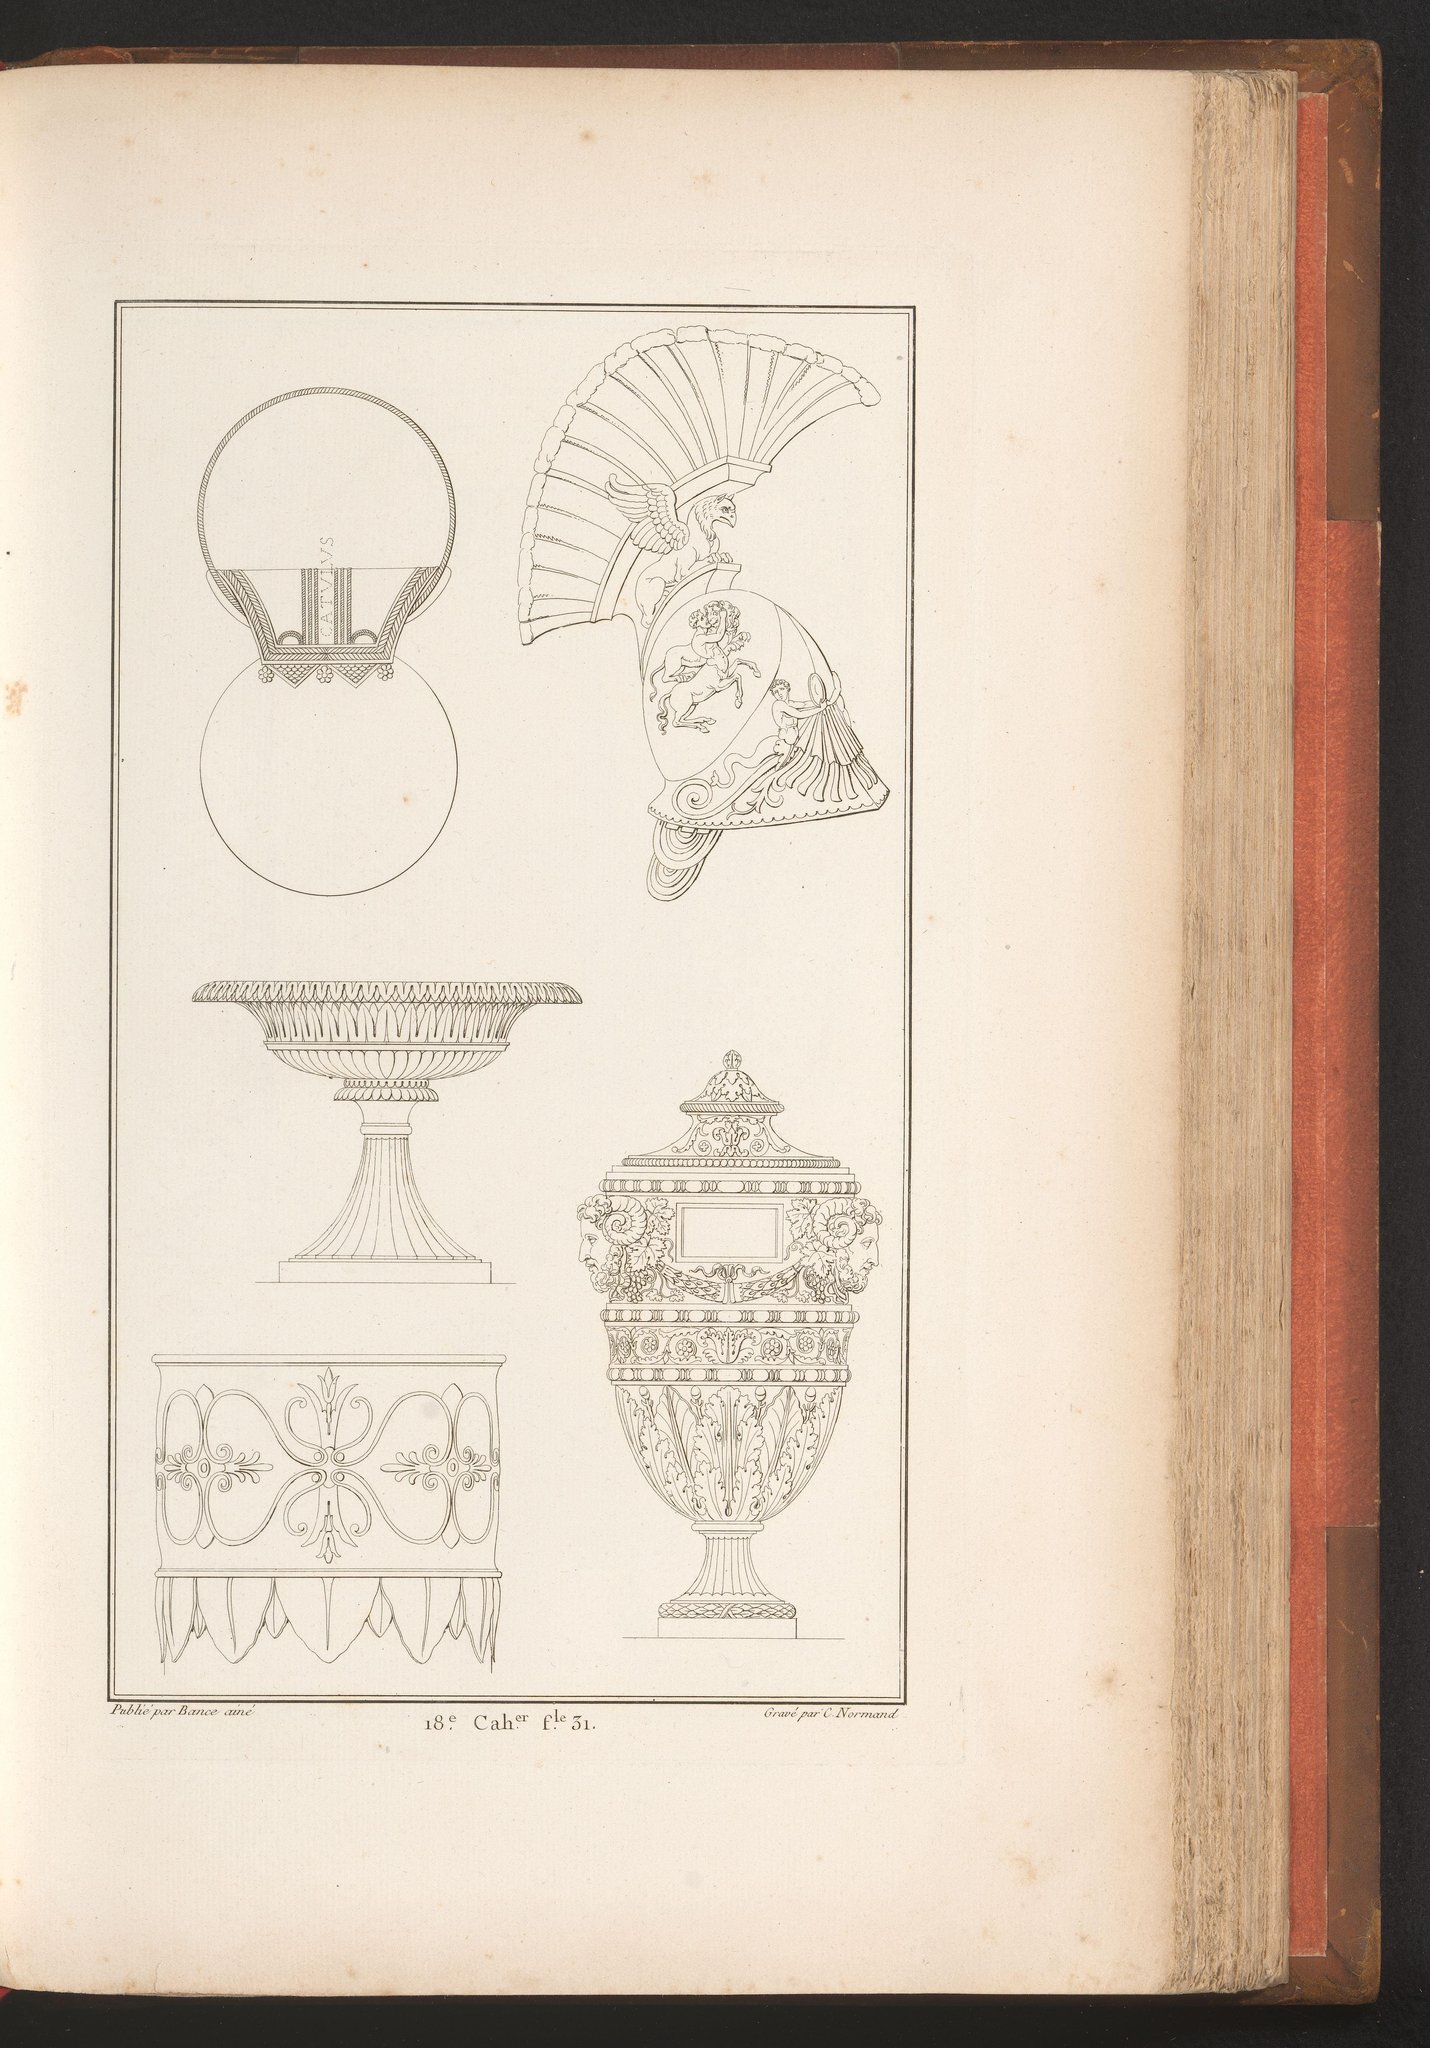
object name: ornament print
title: Diverse ornamenten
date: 1820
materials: paper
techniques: etching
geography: paris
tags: ornaments ~ art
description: Ornamentprent met diverse decoratieve objecten. Onderdeel (18e. Cah.er f.le 31) van het prentalbum met twee series van in totaal 138 ornamentprenten door Beauvallet en Normand, 'Fragmens d'Ornemens dans le Style Antique'.